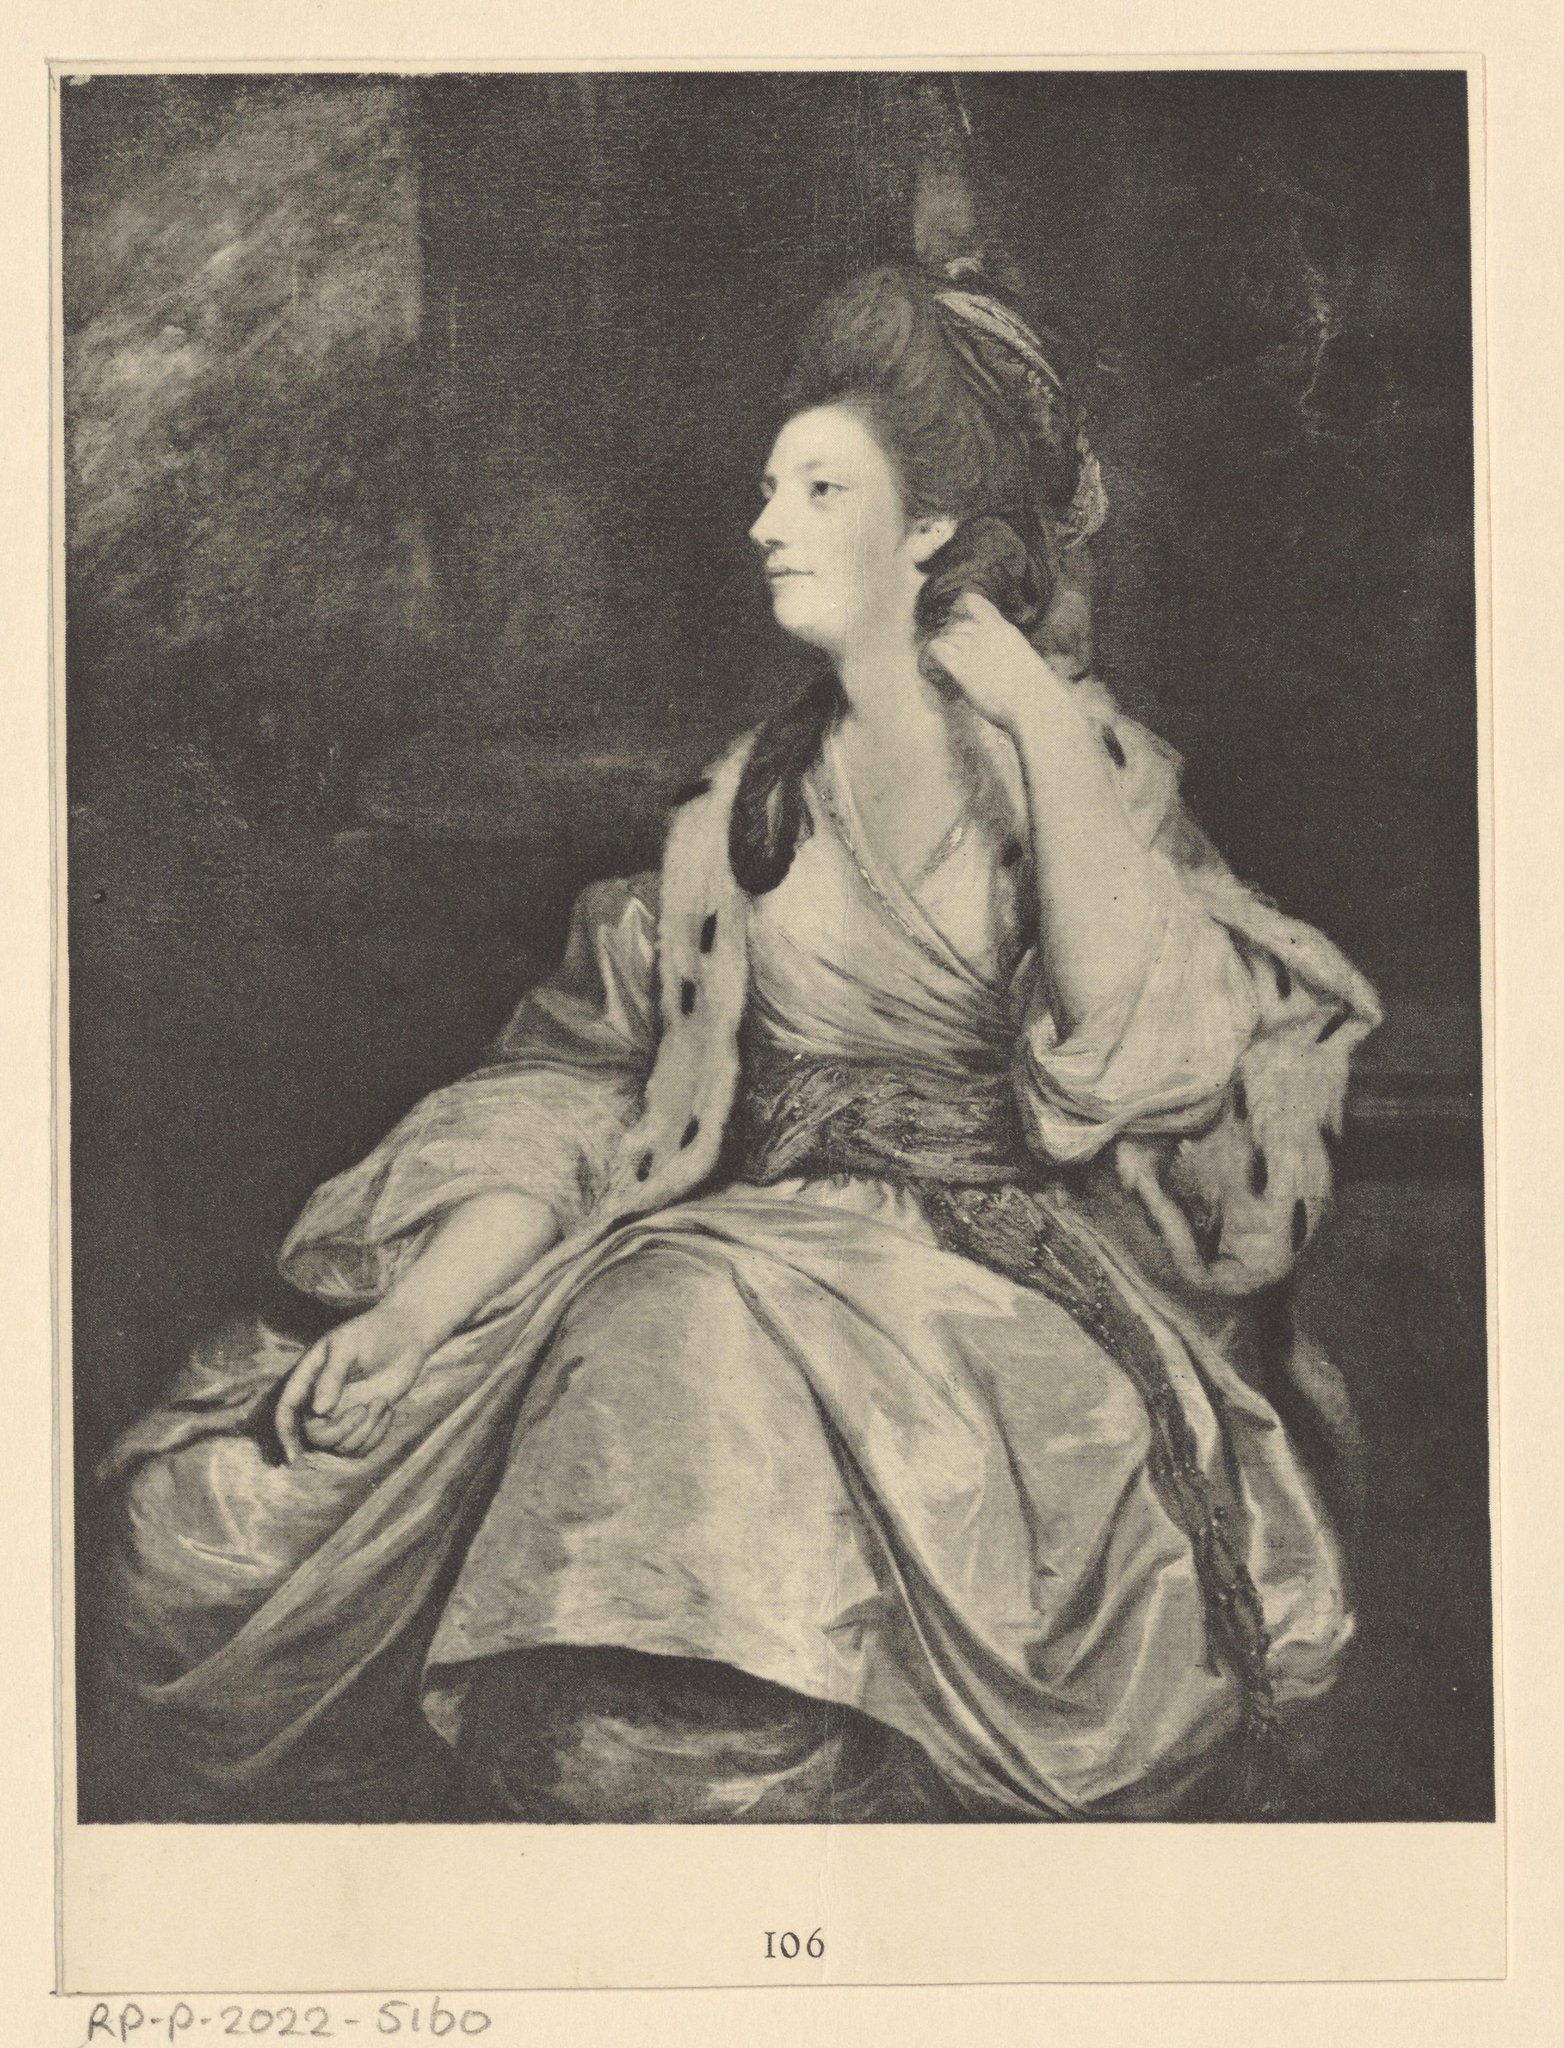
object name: photomechanical print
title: Portret van Elizabeth Ramsden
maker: Anonymous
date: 1932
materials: paper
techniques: rotogravure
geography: england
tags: historical persons - bb - woman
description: Prent uit: Veilingcatalogus van Christie's Londen, 27 mei 1932. Vermeld als Mrs. Weddell, de getrouwde naam van de geportretteerde.